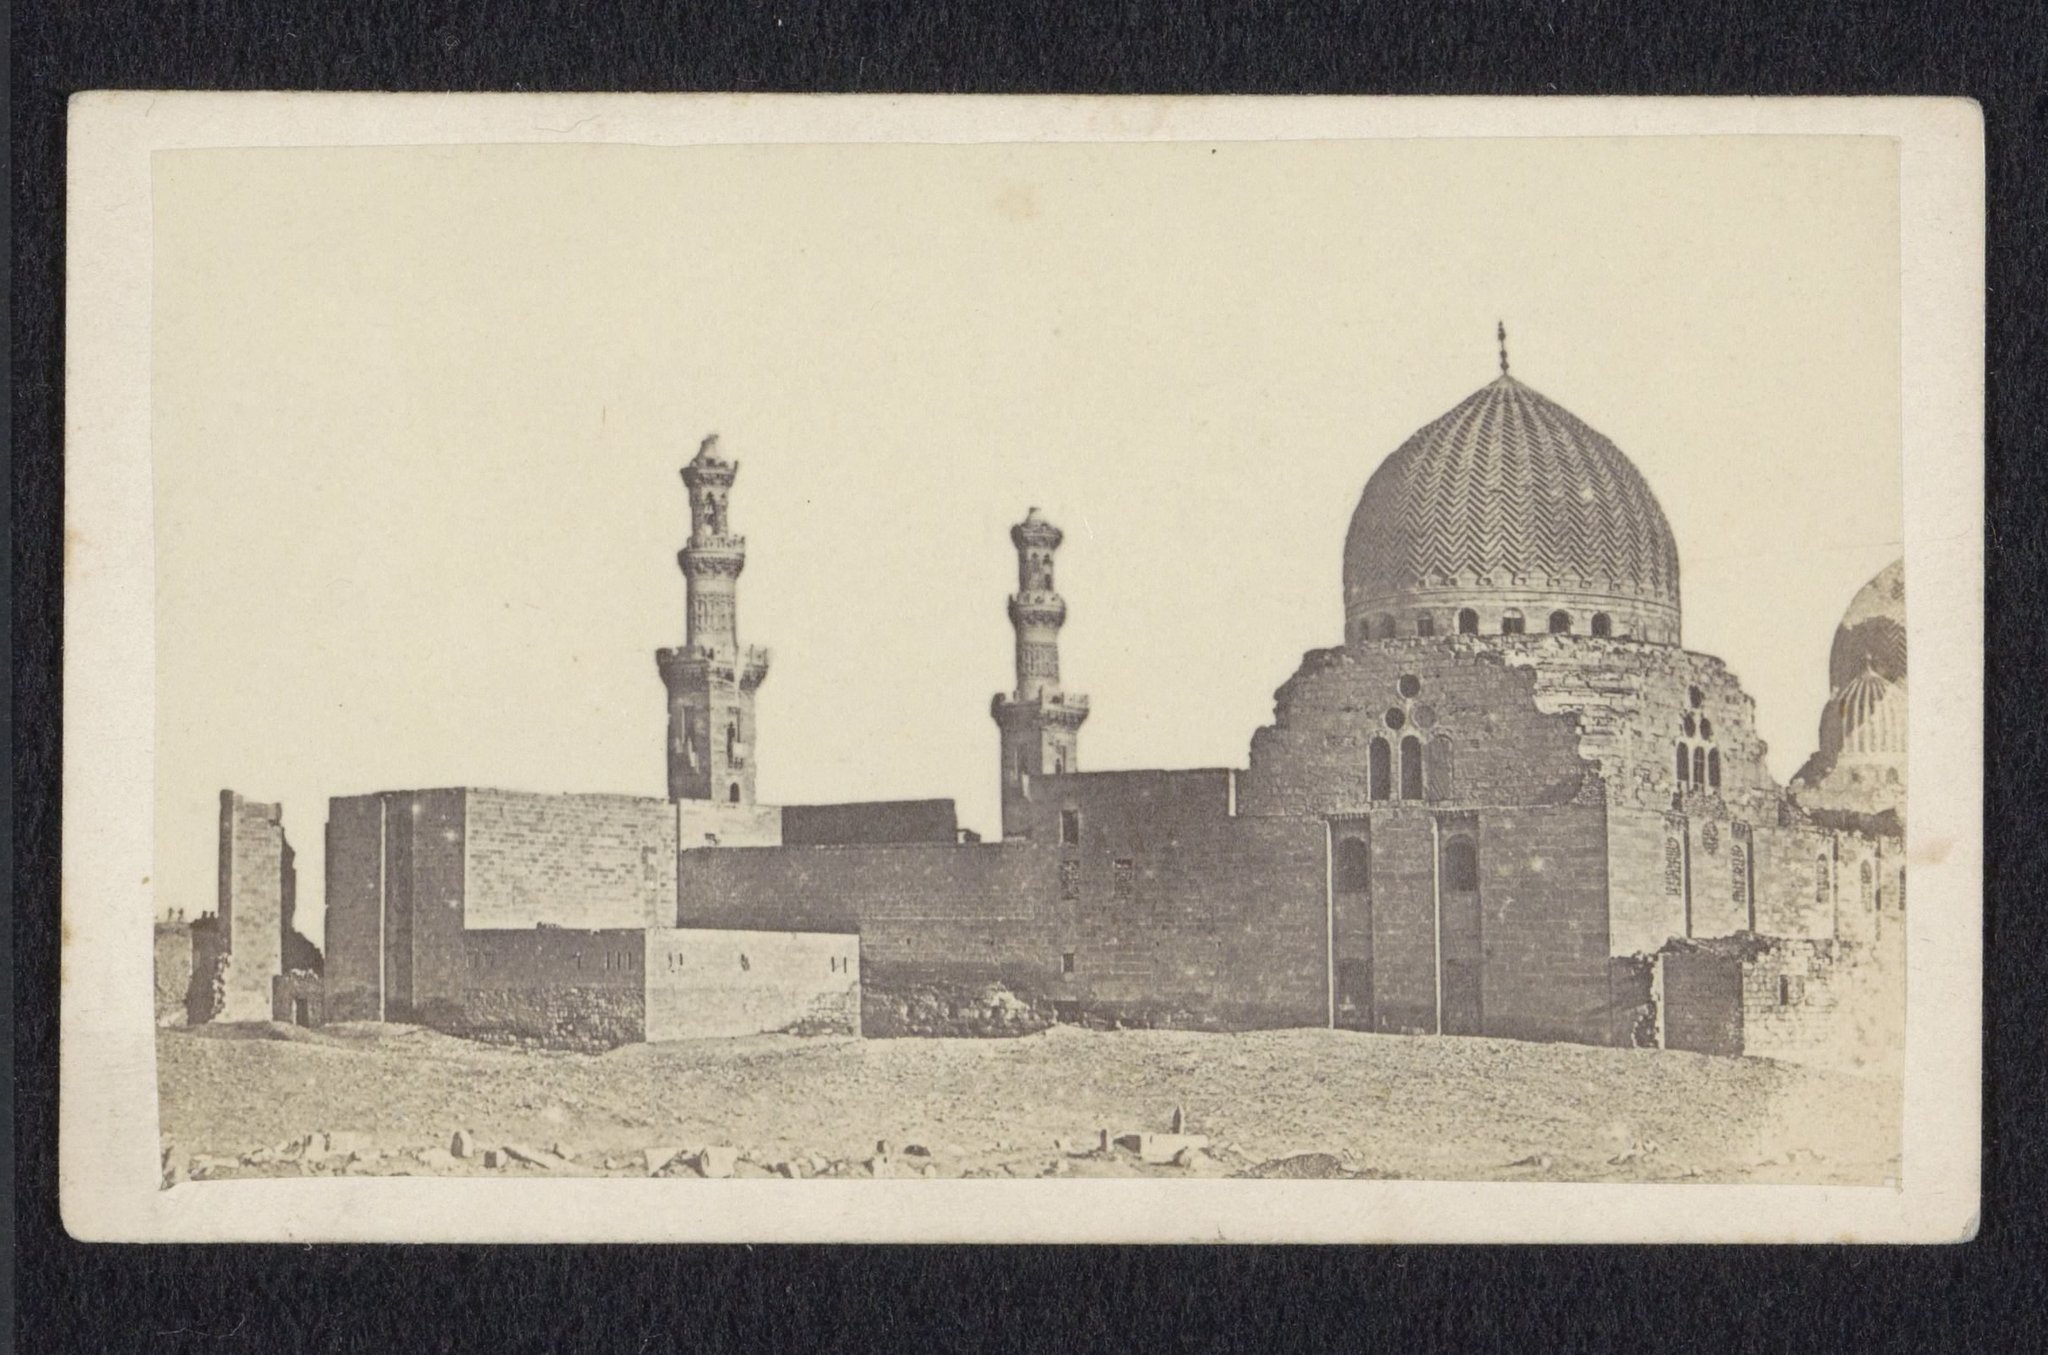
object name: carte de visite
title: Graven van de Kaliefen, Caïro, Egypte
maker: antonio beato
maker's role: fotograaf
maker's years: 1835-1906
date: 1859-1862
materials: cardboard, paper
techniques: albumen print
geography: cairo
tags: grave-building, monumental tomb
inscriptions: inscription: ‘Mosque de Sultan [...]’